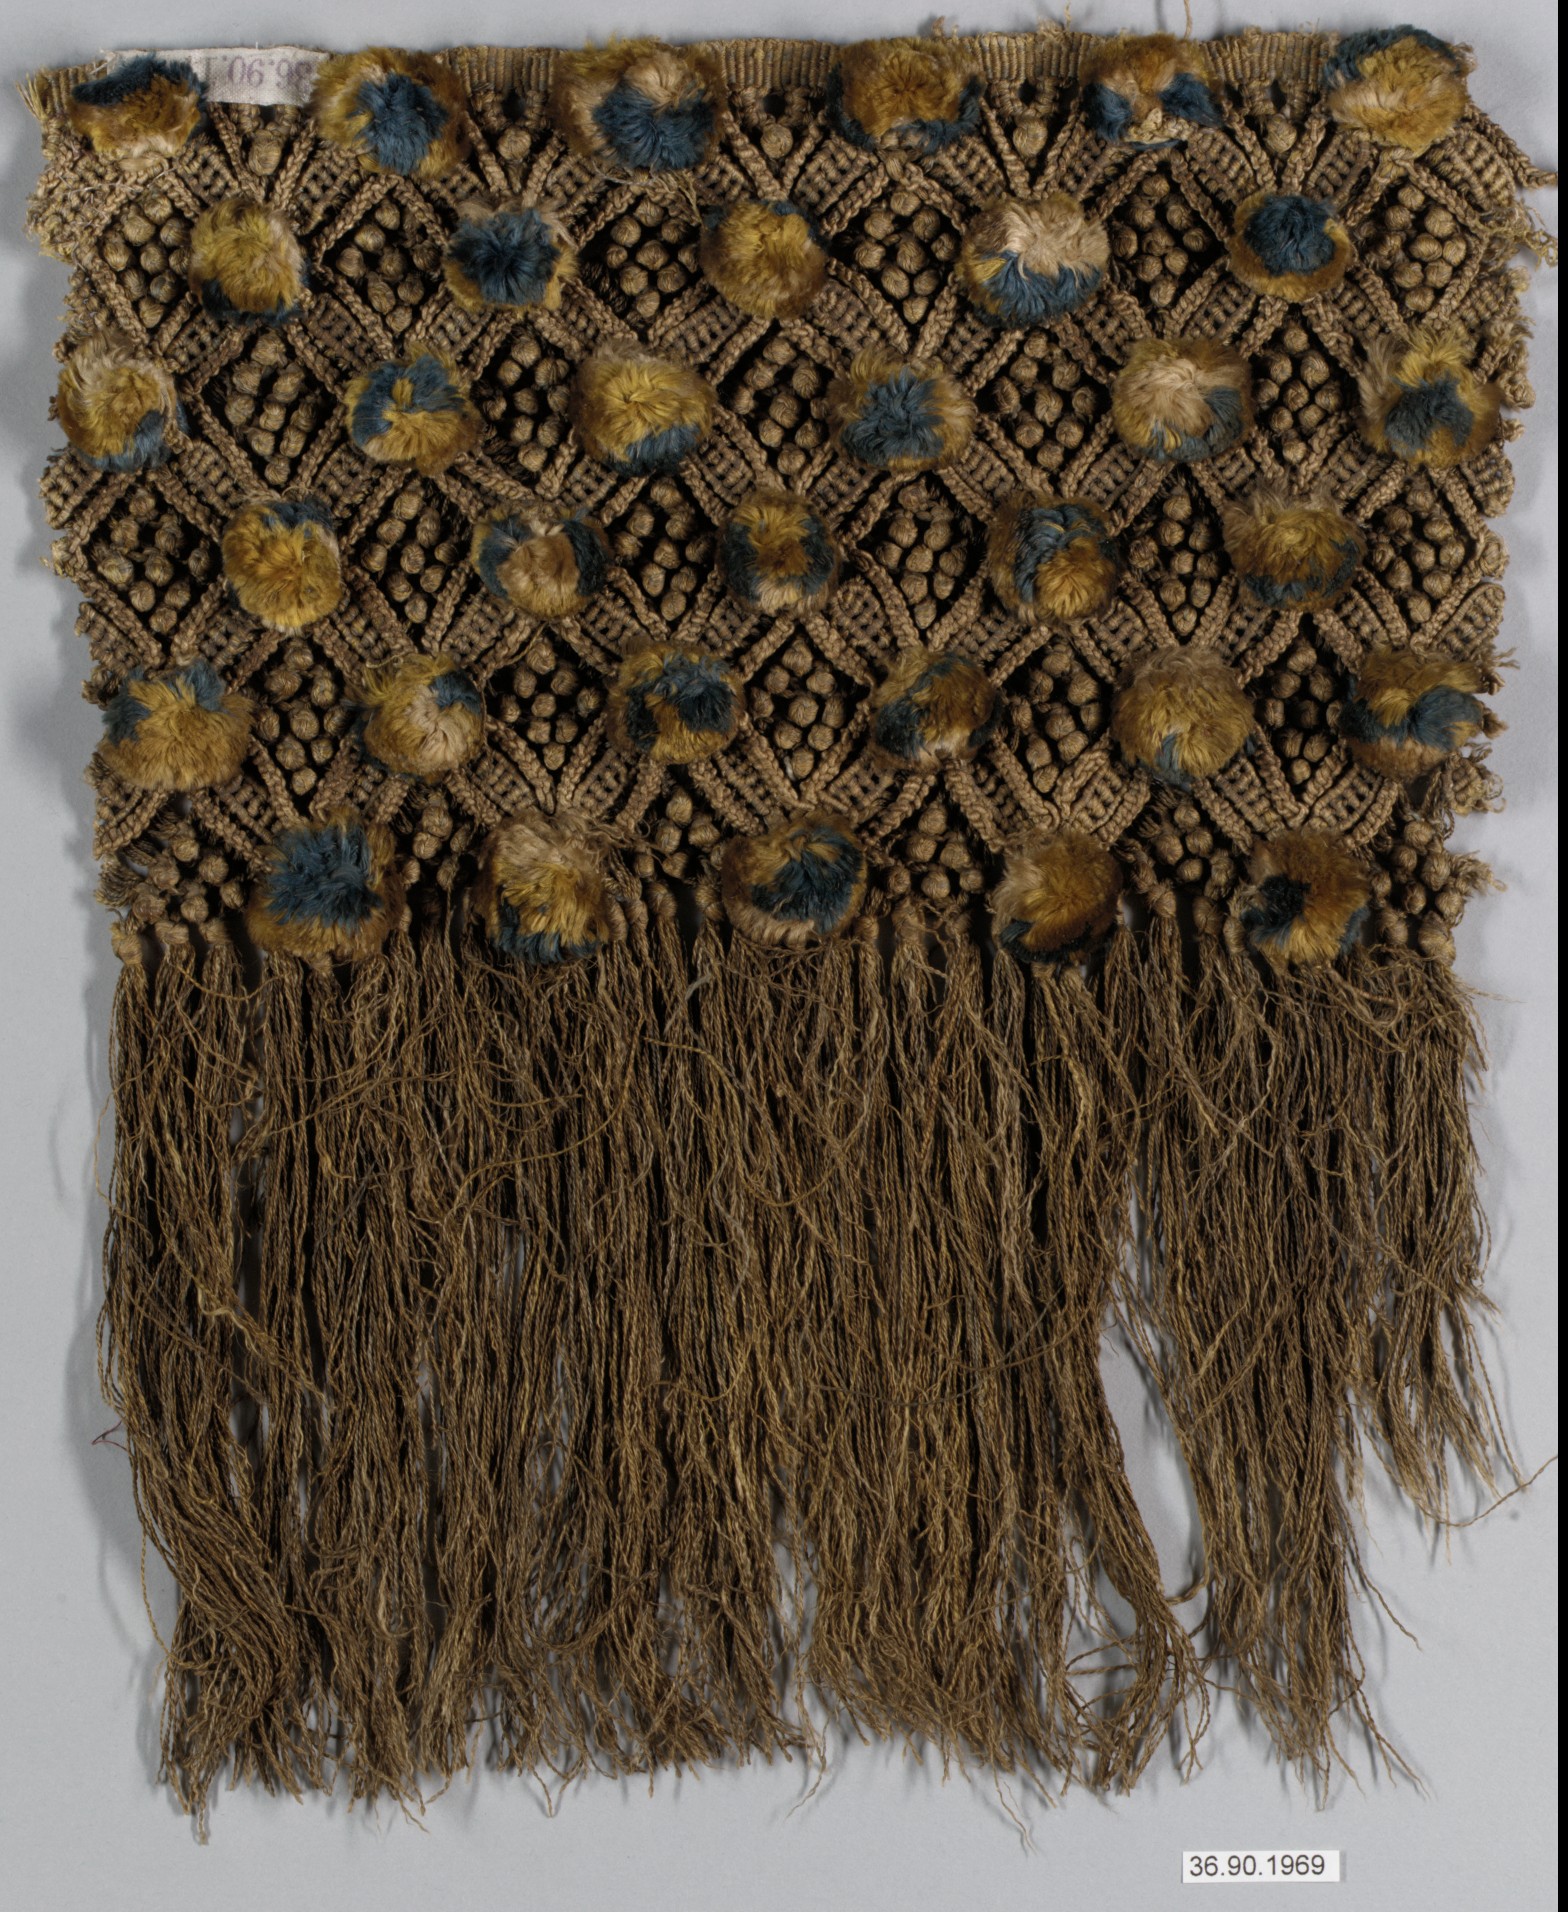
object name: fringe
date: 1701-1800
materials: silk